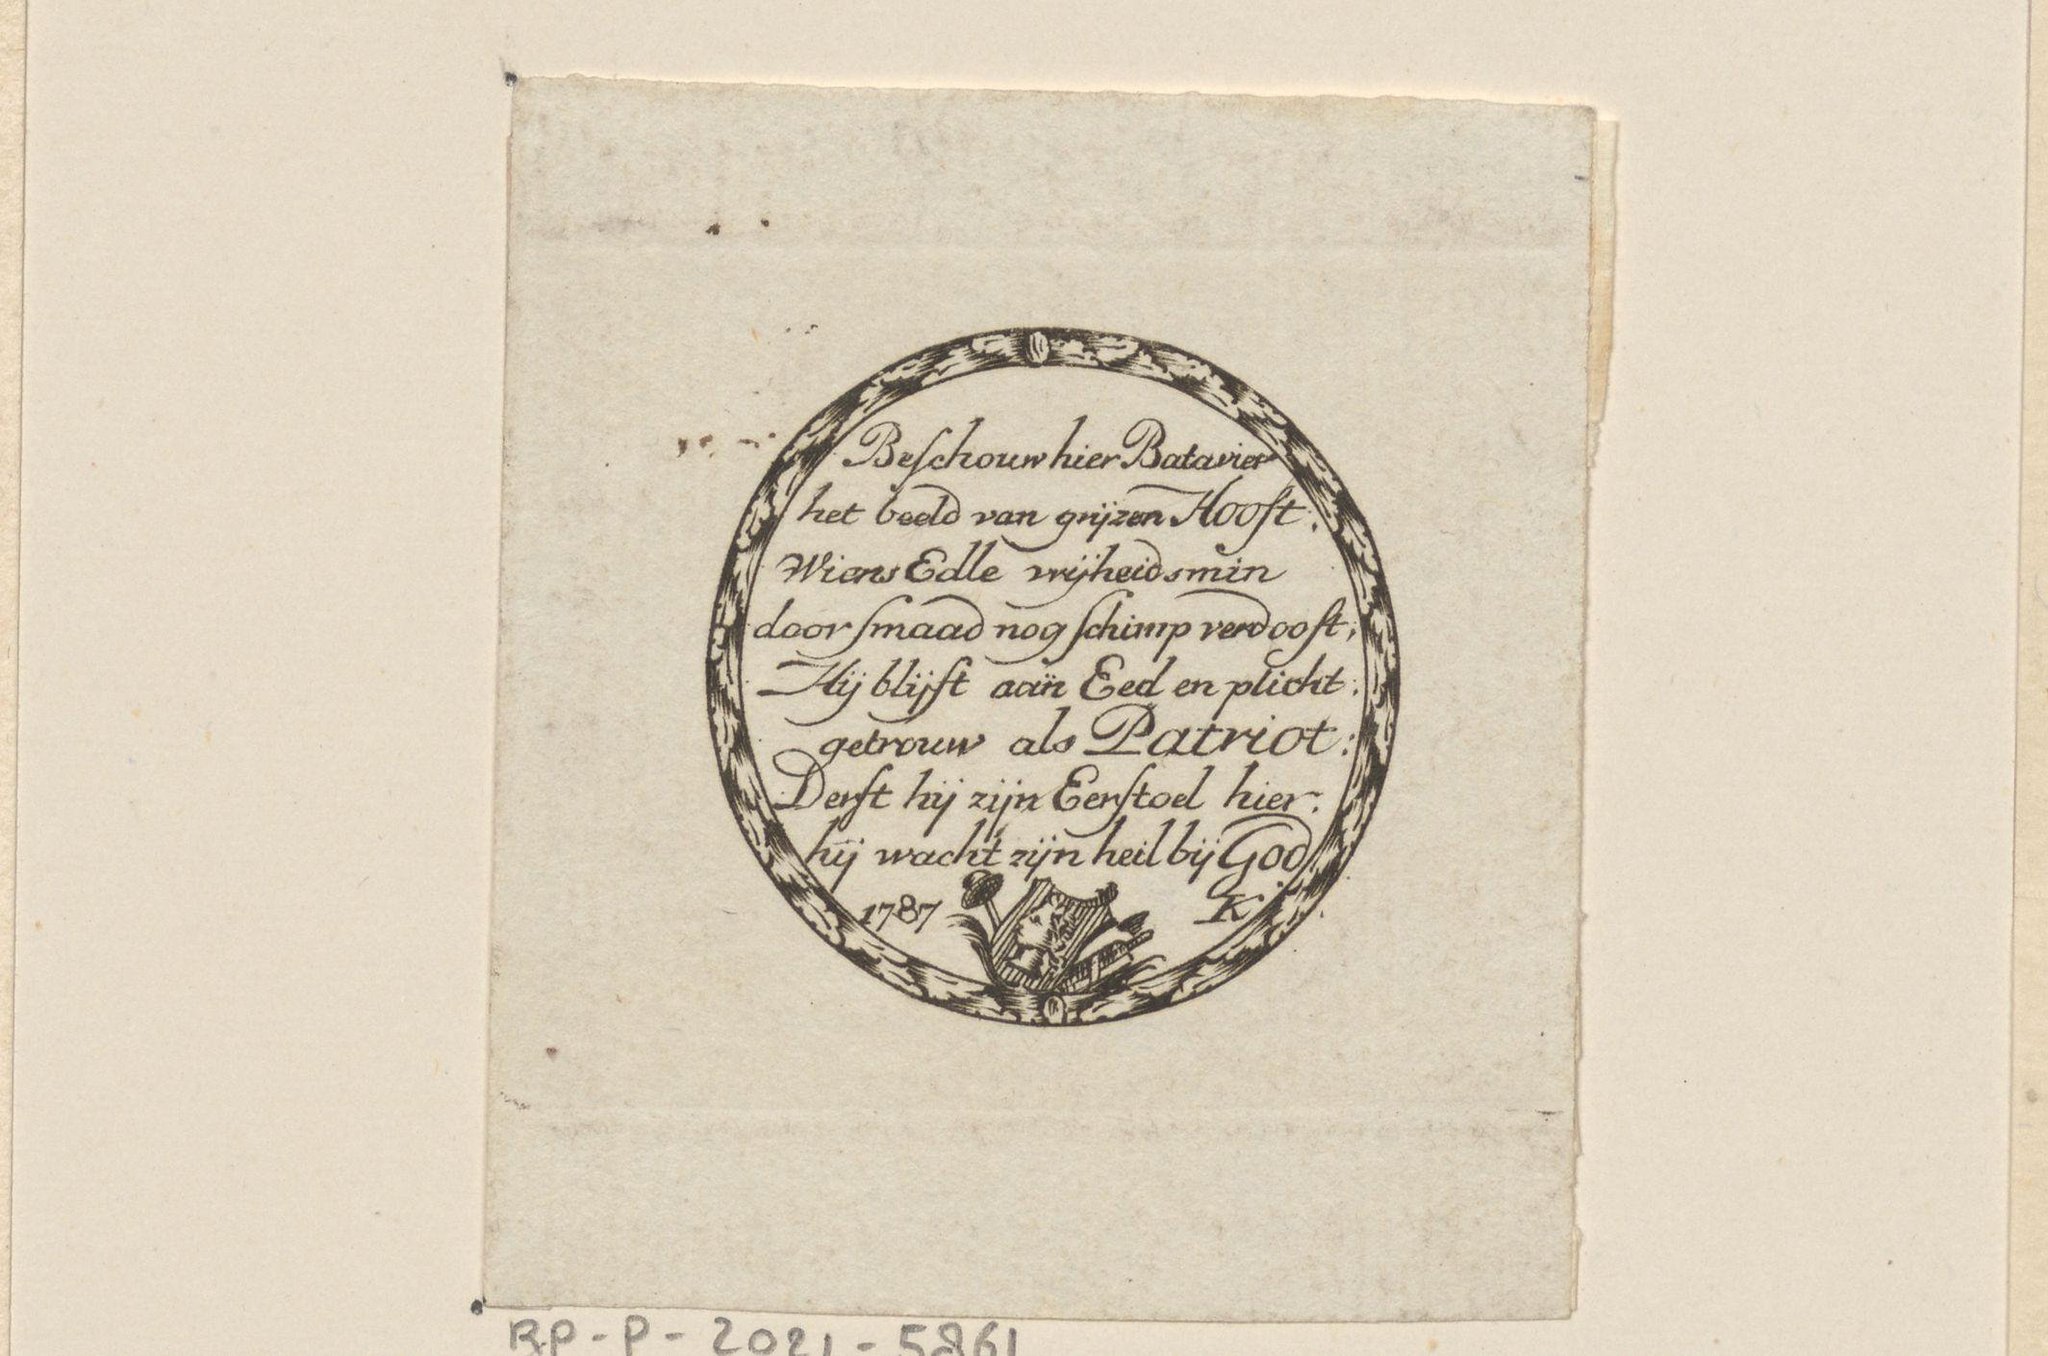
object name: print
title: Bijschrift bij een portret van Hendrik Danielsz. Hooft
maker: Anonymous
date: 1787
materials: paper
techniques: engraving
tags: mayor, hendrik danielsz. hooft, armorial bearing, heraldry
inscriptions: date